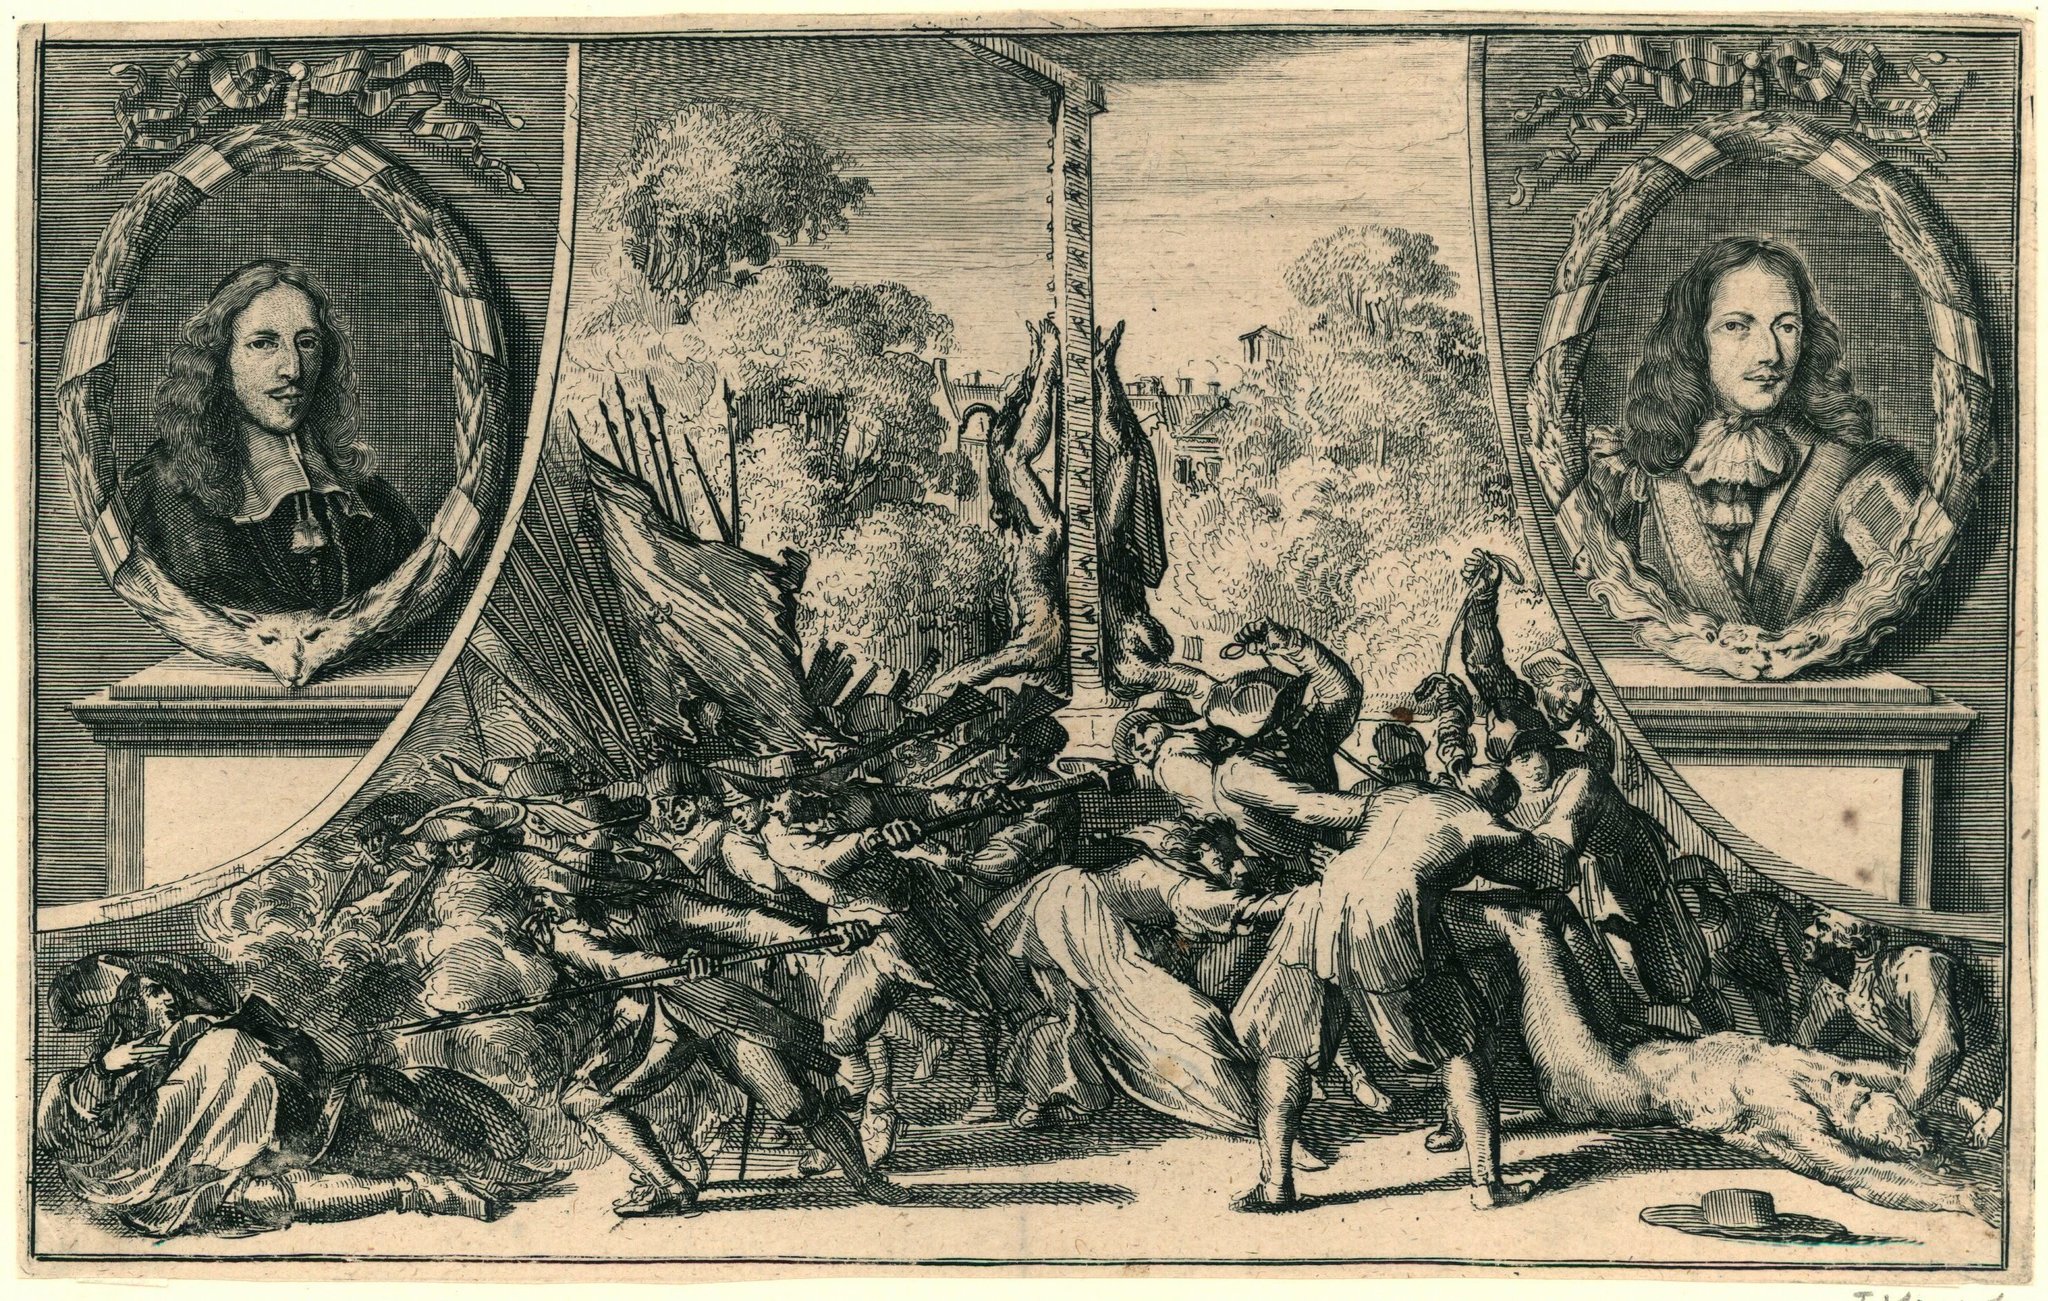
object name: print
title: De moord op de gebroeders De Witt en twee portretten, 1672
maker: Anonymous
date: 1672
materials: paper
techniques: engraving, etching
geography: northern netherlands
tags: dordrecht, cornelis de witt, the hague, politician, johan de witt, mutilation of the corpse, lynching, attempt, political murder, violent death, being killed; being mishandled and maltreated; seeking death (+ death by lynching)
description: Portretten van Johan en Cornelis de Witt boven een gecombineerde voorstelling van de moord, het slepen van de lichamen naar de wip en de verminking van de lijken, 20 augustus 1672.